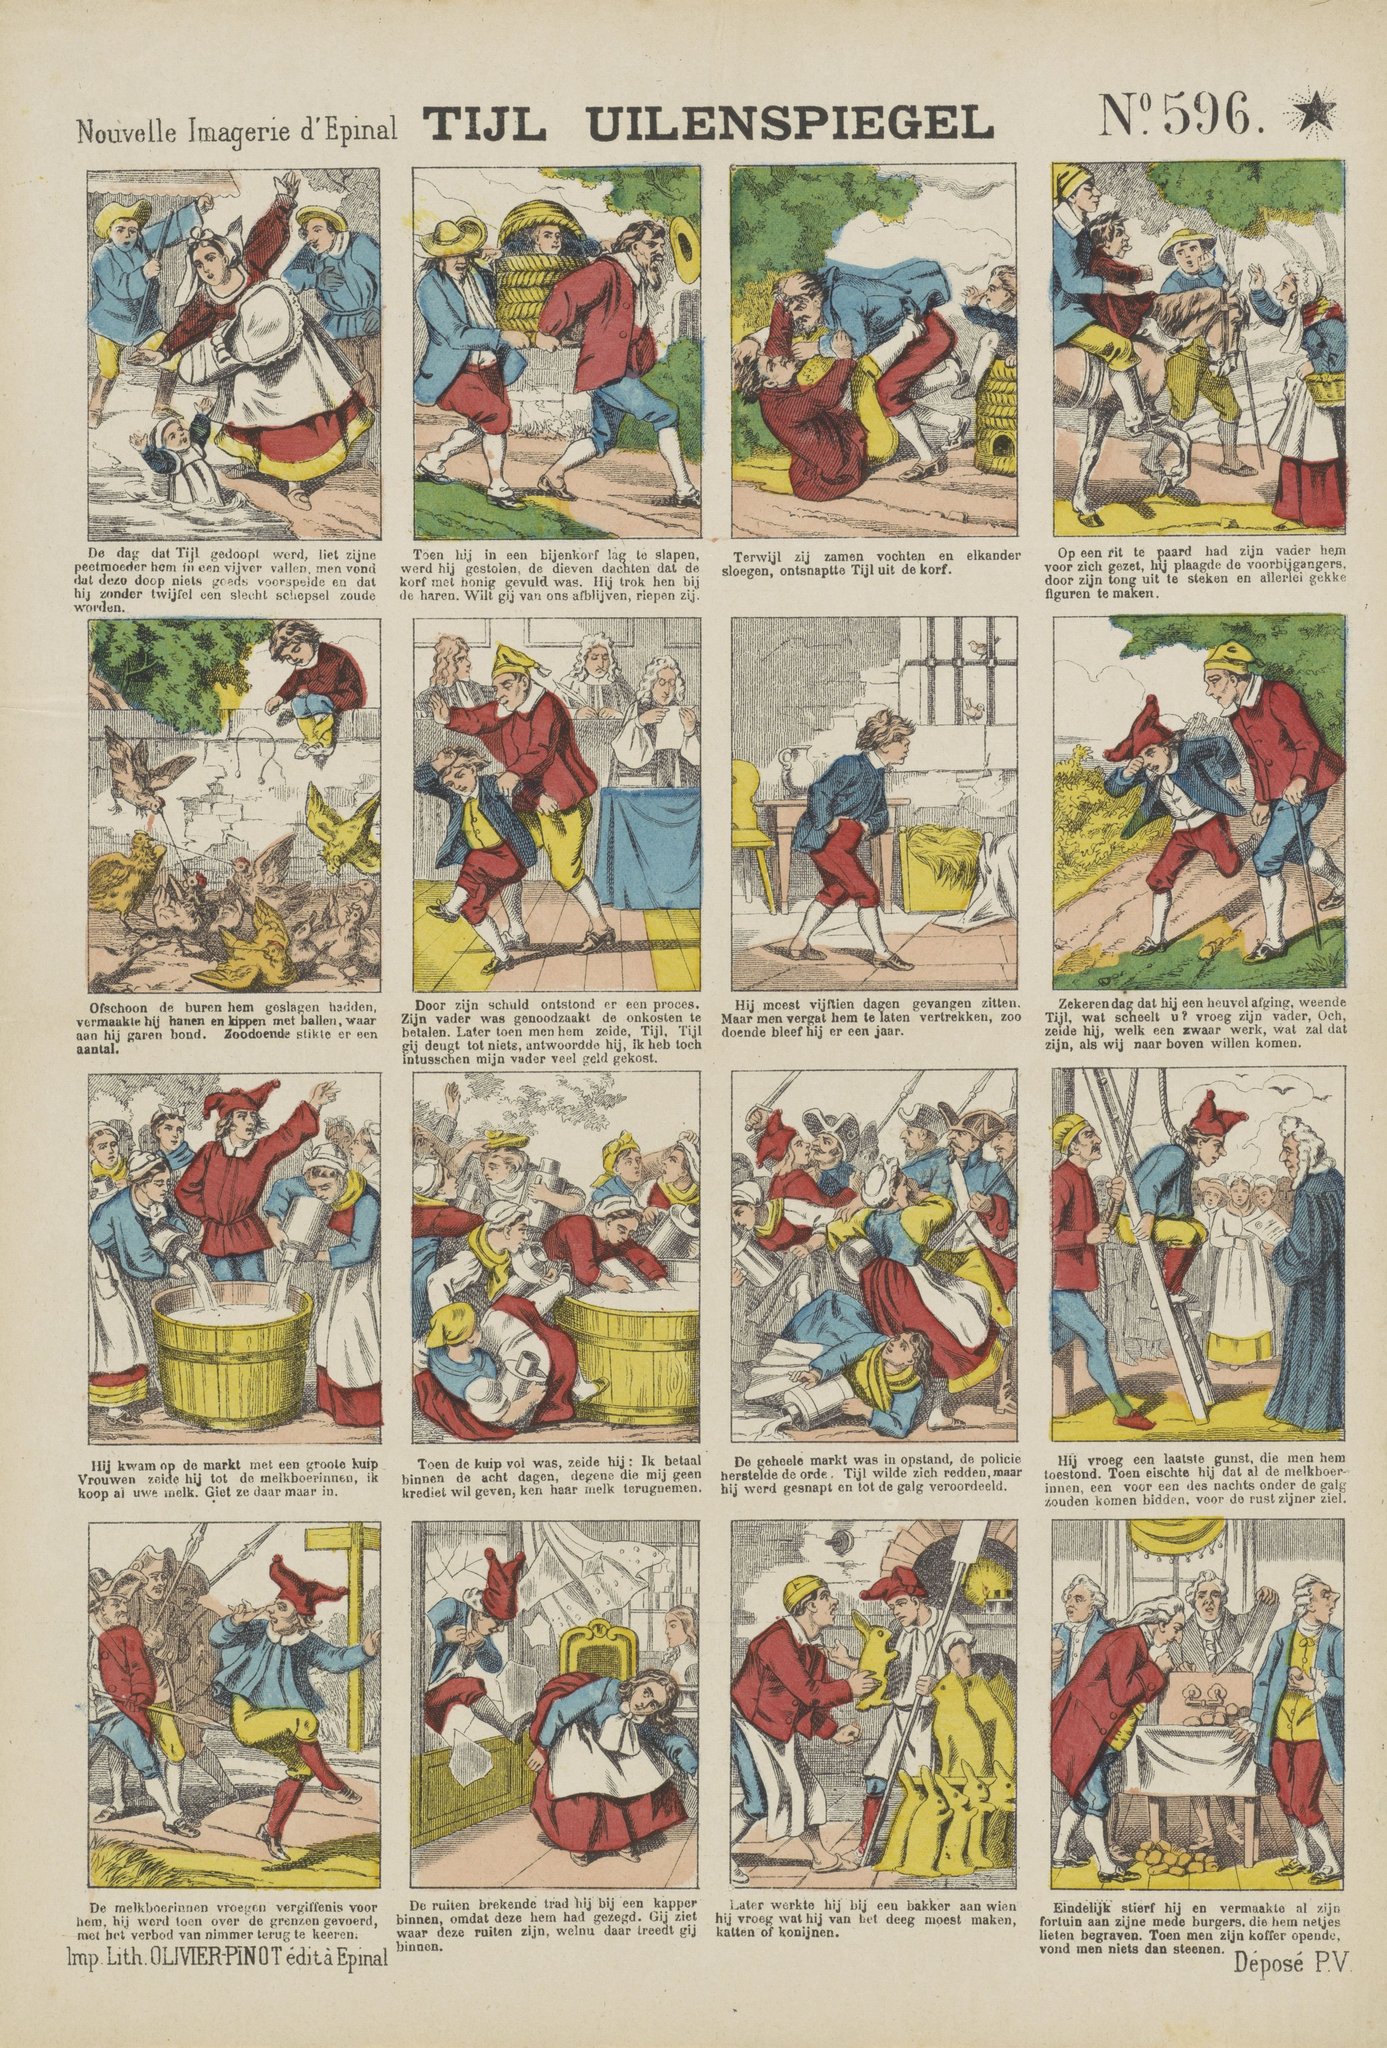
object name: print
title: Tijl Uilenspiegel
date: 1874-1888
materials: paper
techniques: colour, letterpress printing, lithograph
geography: europe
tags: eulenspiegel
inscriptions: collector's mark: Lugt 2760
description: Blad met 16 voorstellingen over het leven van Tijl Uilenspiegel. Onder elke voorstelling een onderschrift in het Nederlands. Genummerd rechtsboven: No. 596.